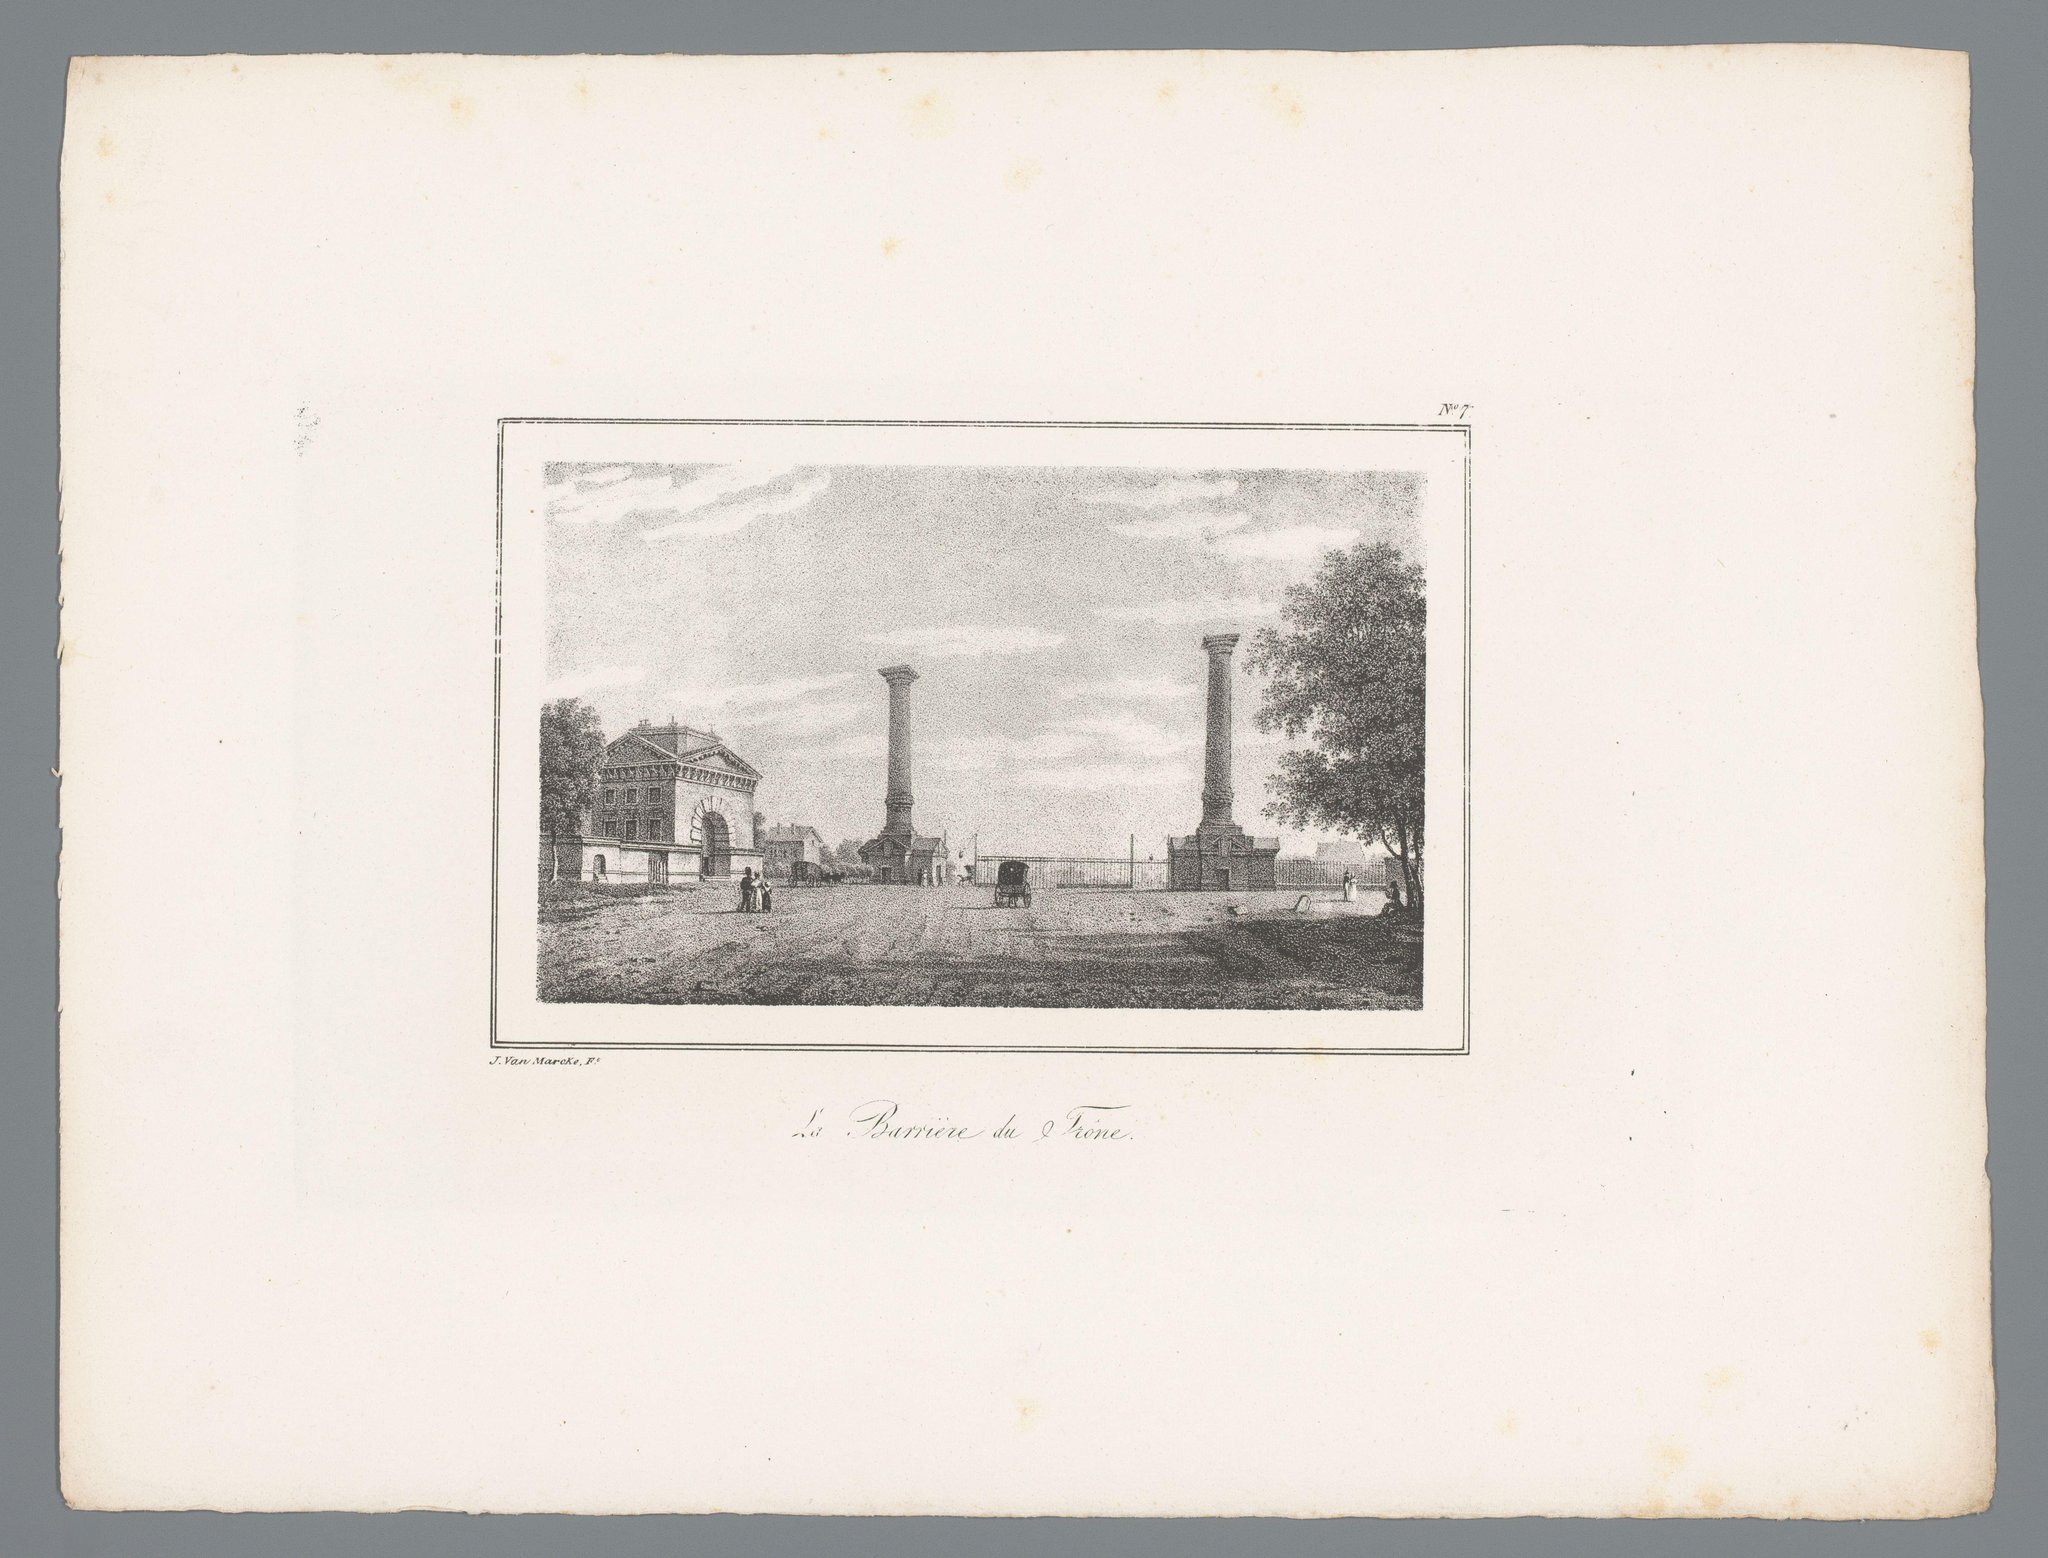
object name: print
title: La Barrière du Trône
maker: jean baptiste van marcke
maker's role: print maker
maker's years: 1798-1849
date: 1808-1849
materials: paper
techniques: lithograph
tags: column, pillar ~ architecture, city-view in general; 'veduta', paris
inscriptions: collector's mark: Lugt 2228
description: In de inventaris getiteld: Vues principales de Paris. Reeks van 28 nummers. Met adres van Décrounau. Jules David, van Marke, Noël en Victor Adam. De prent is mogelijk onderdeel van een serie.